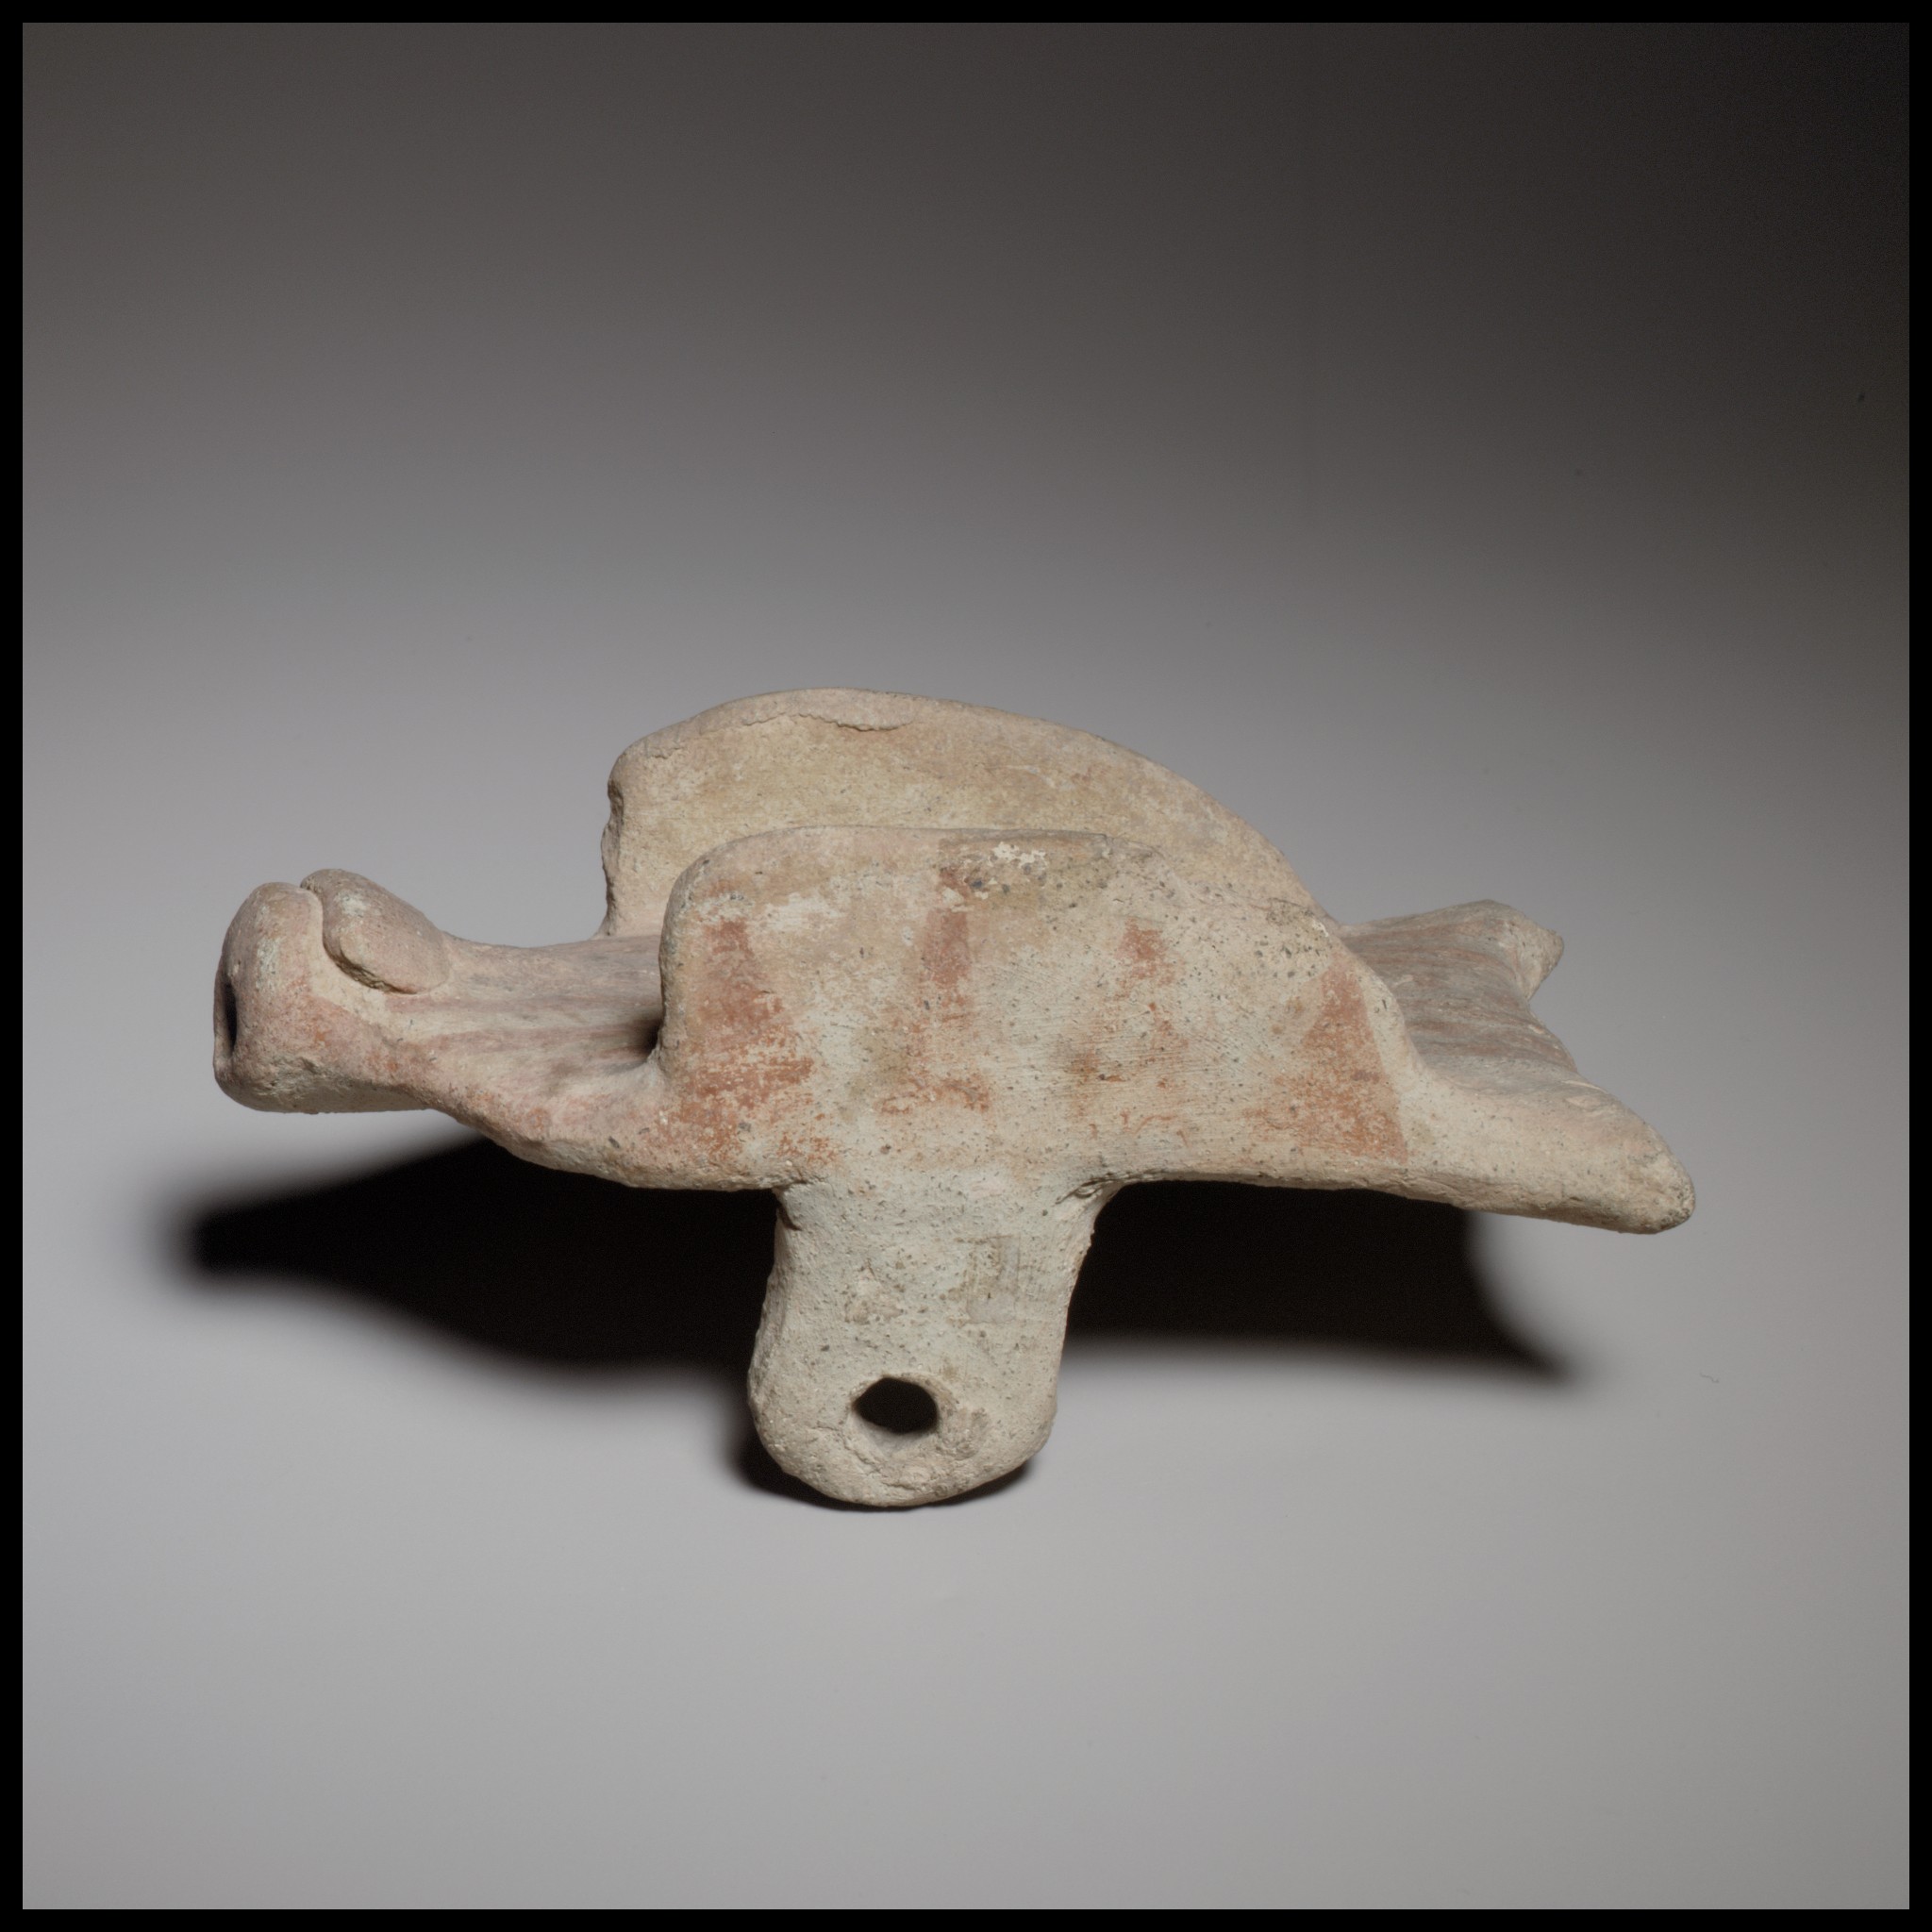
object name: model of a cart, empty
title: Model of a cart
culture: cypriot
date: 600-501 BCE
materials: terracotta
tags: carts